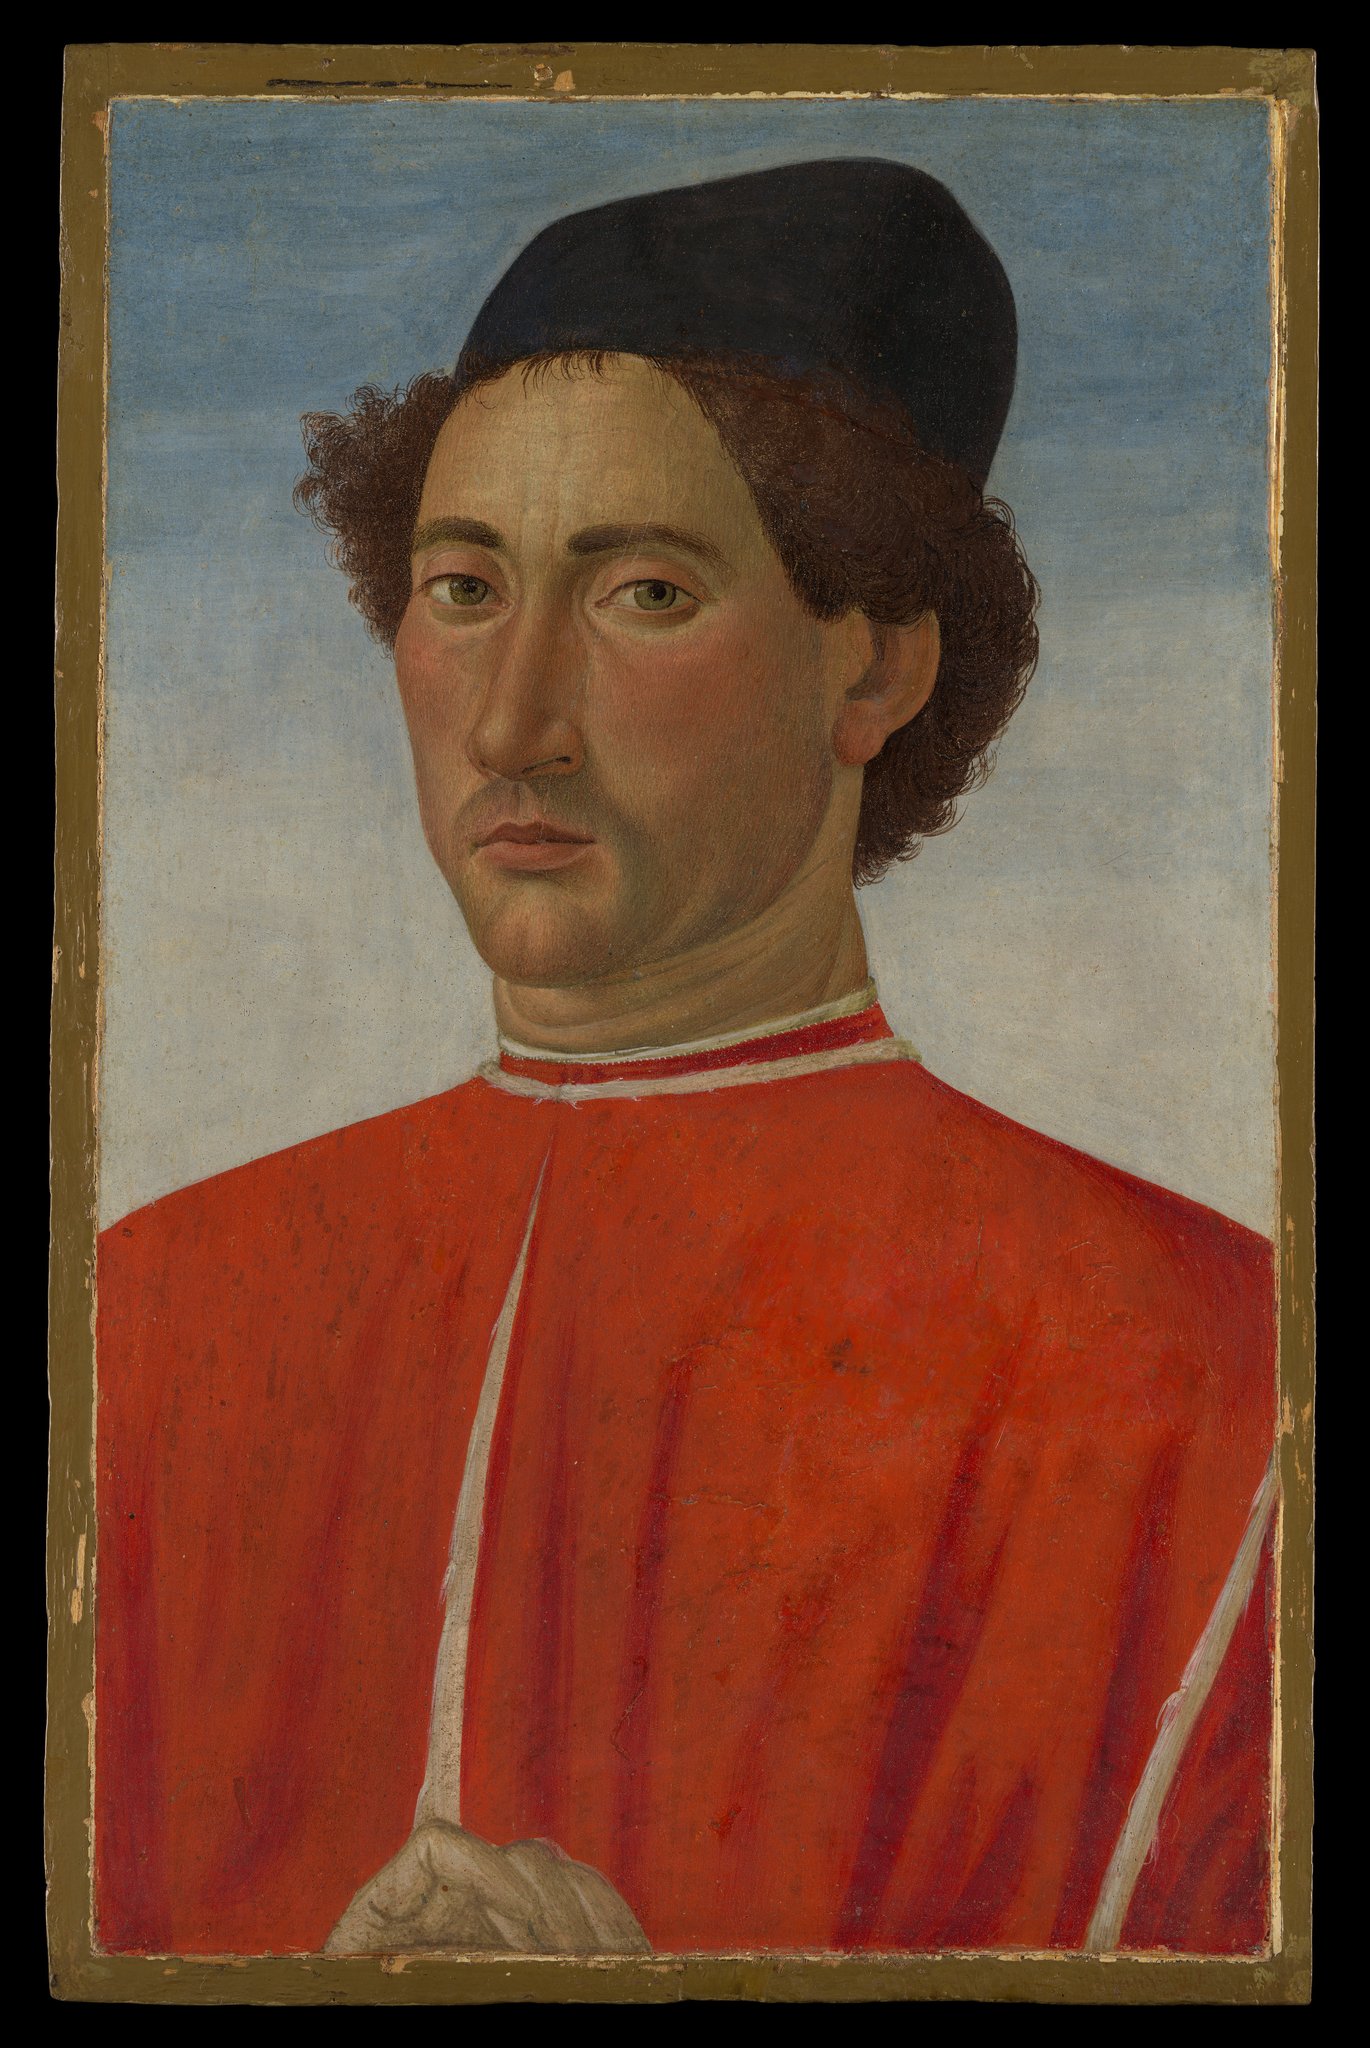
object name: painting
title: Portrait of a Man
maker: cosimo rosselli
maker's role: artist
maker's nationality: italian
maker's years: 1440-1507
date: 1481-1482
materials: paint, wood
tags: men,portraits